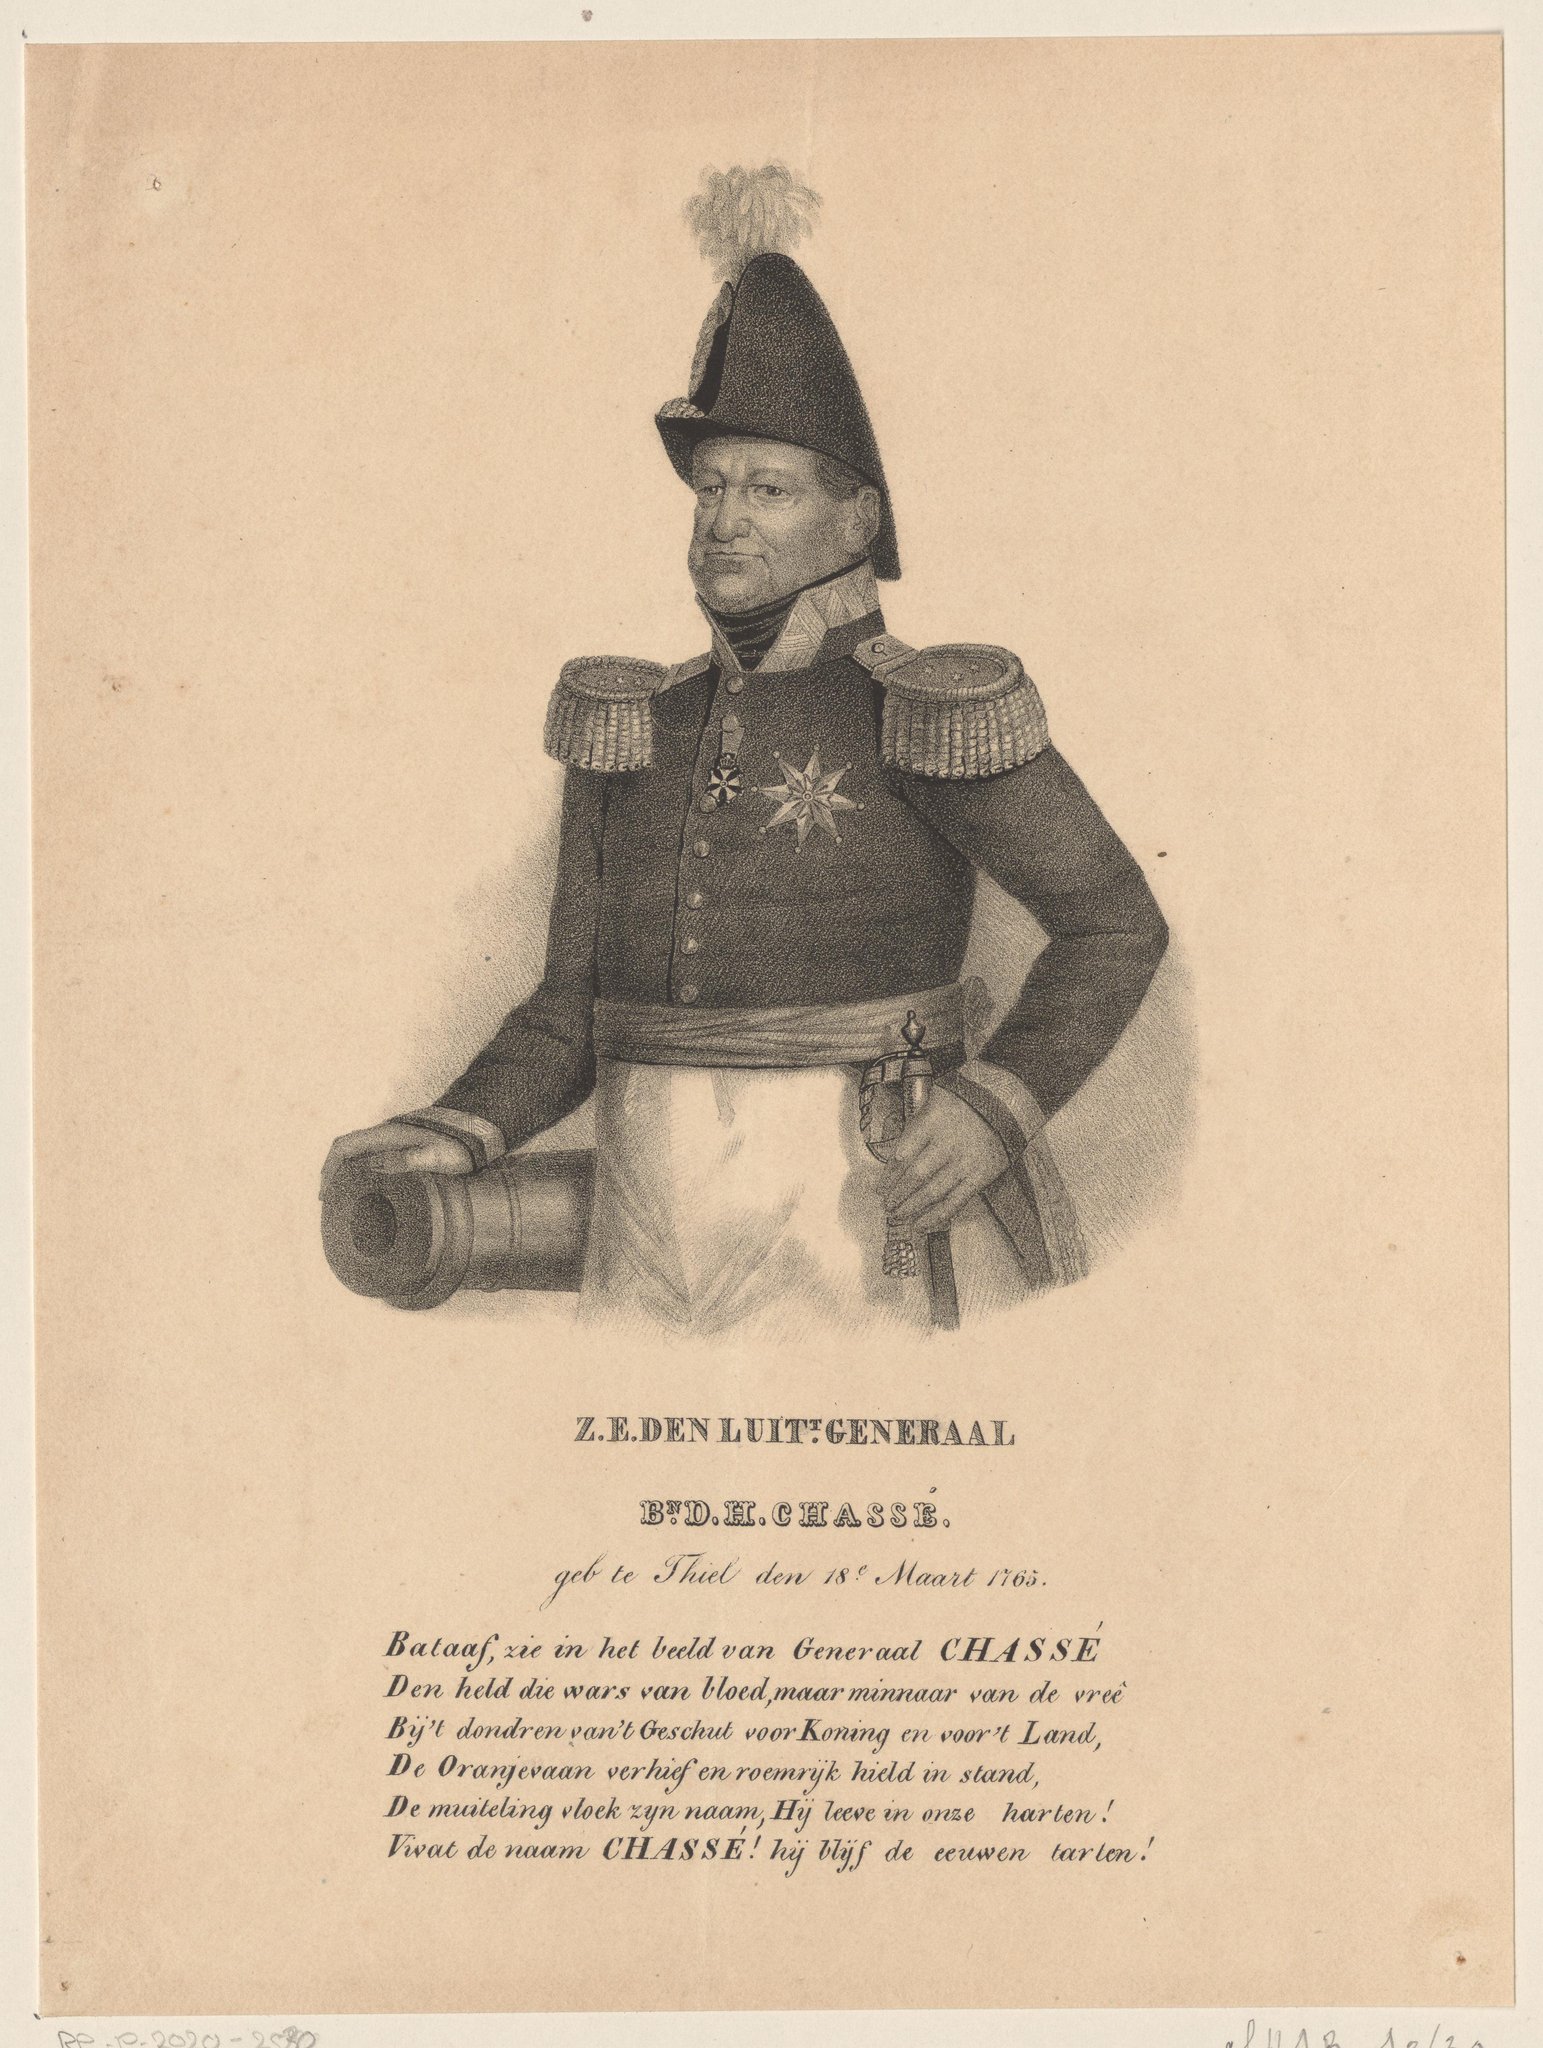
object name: print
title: Portret van David Hendrik baron Chassé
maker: Anonymous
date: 1830-1849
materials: paper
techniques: lithograph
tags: david hendrik baron chassé, commander-in-chief, general, marshal, historical persons, firearms: cannon